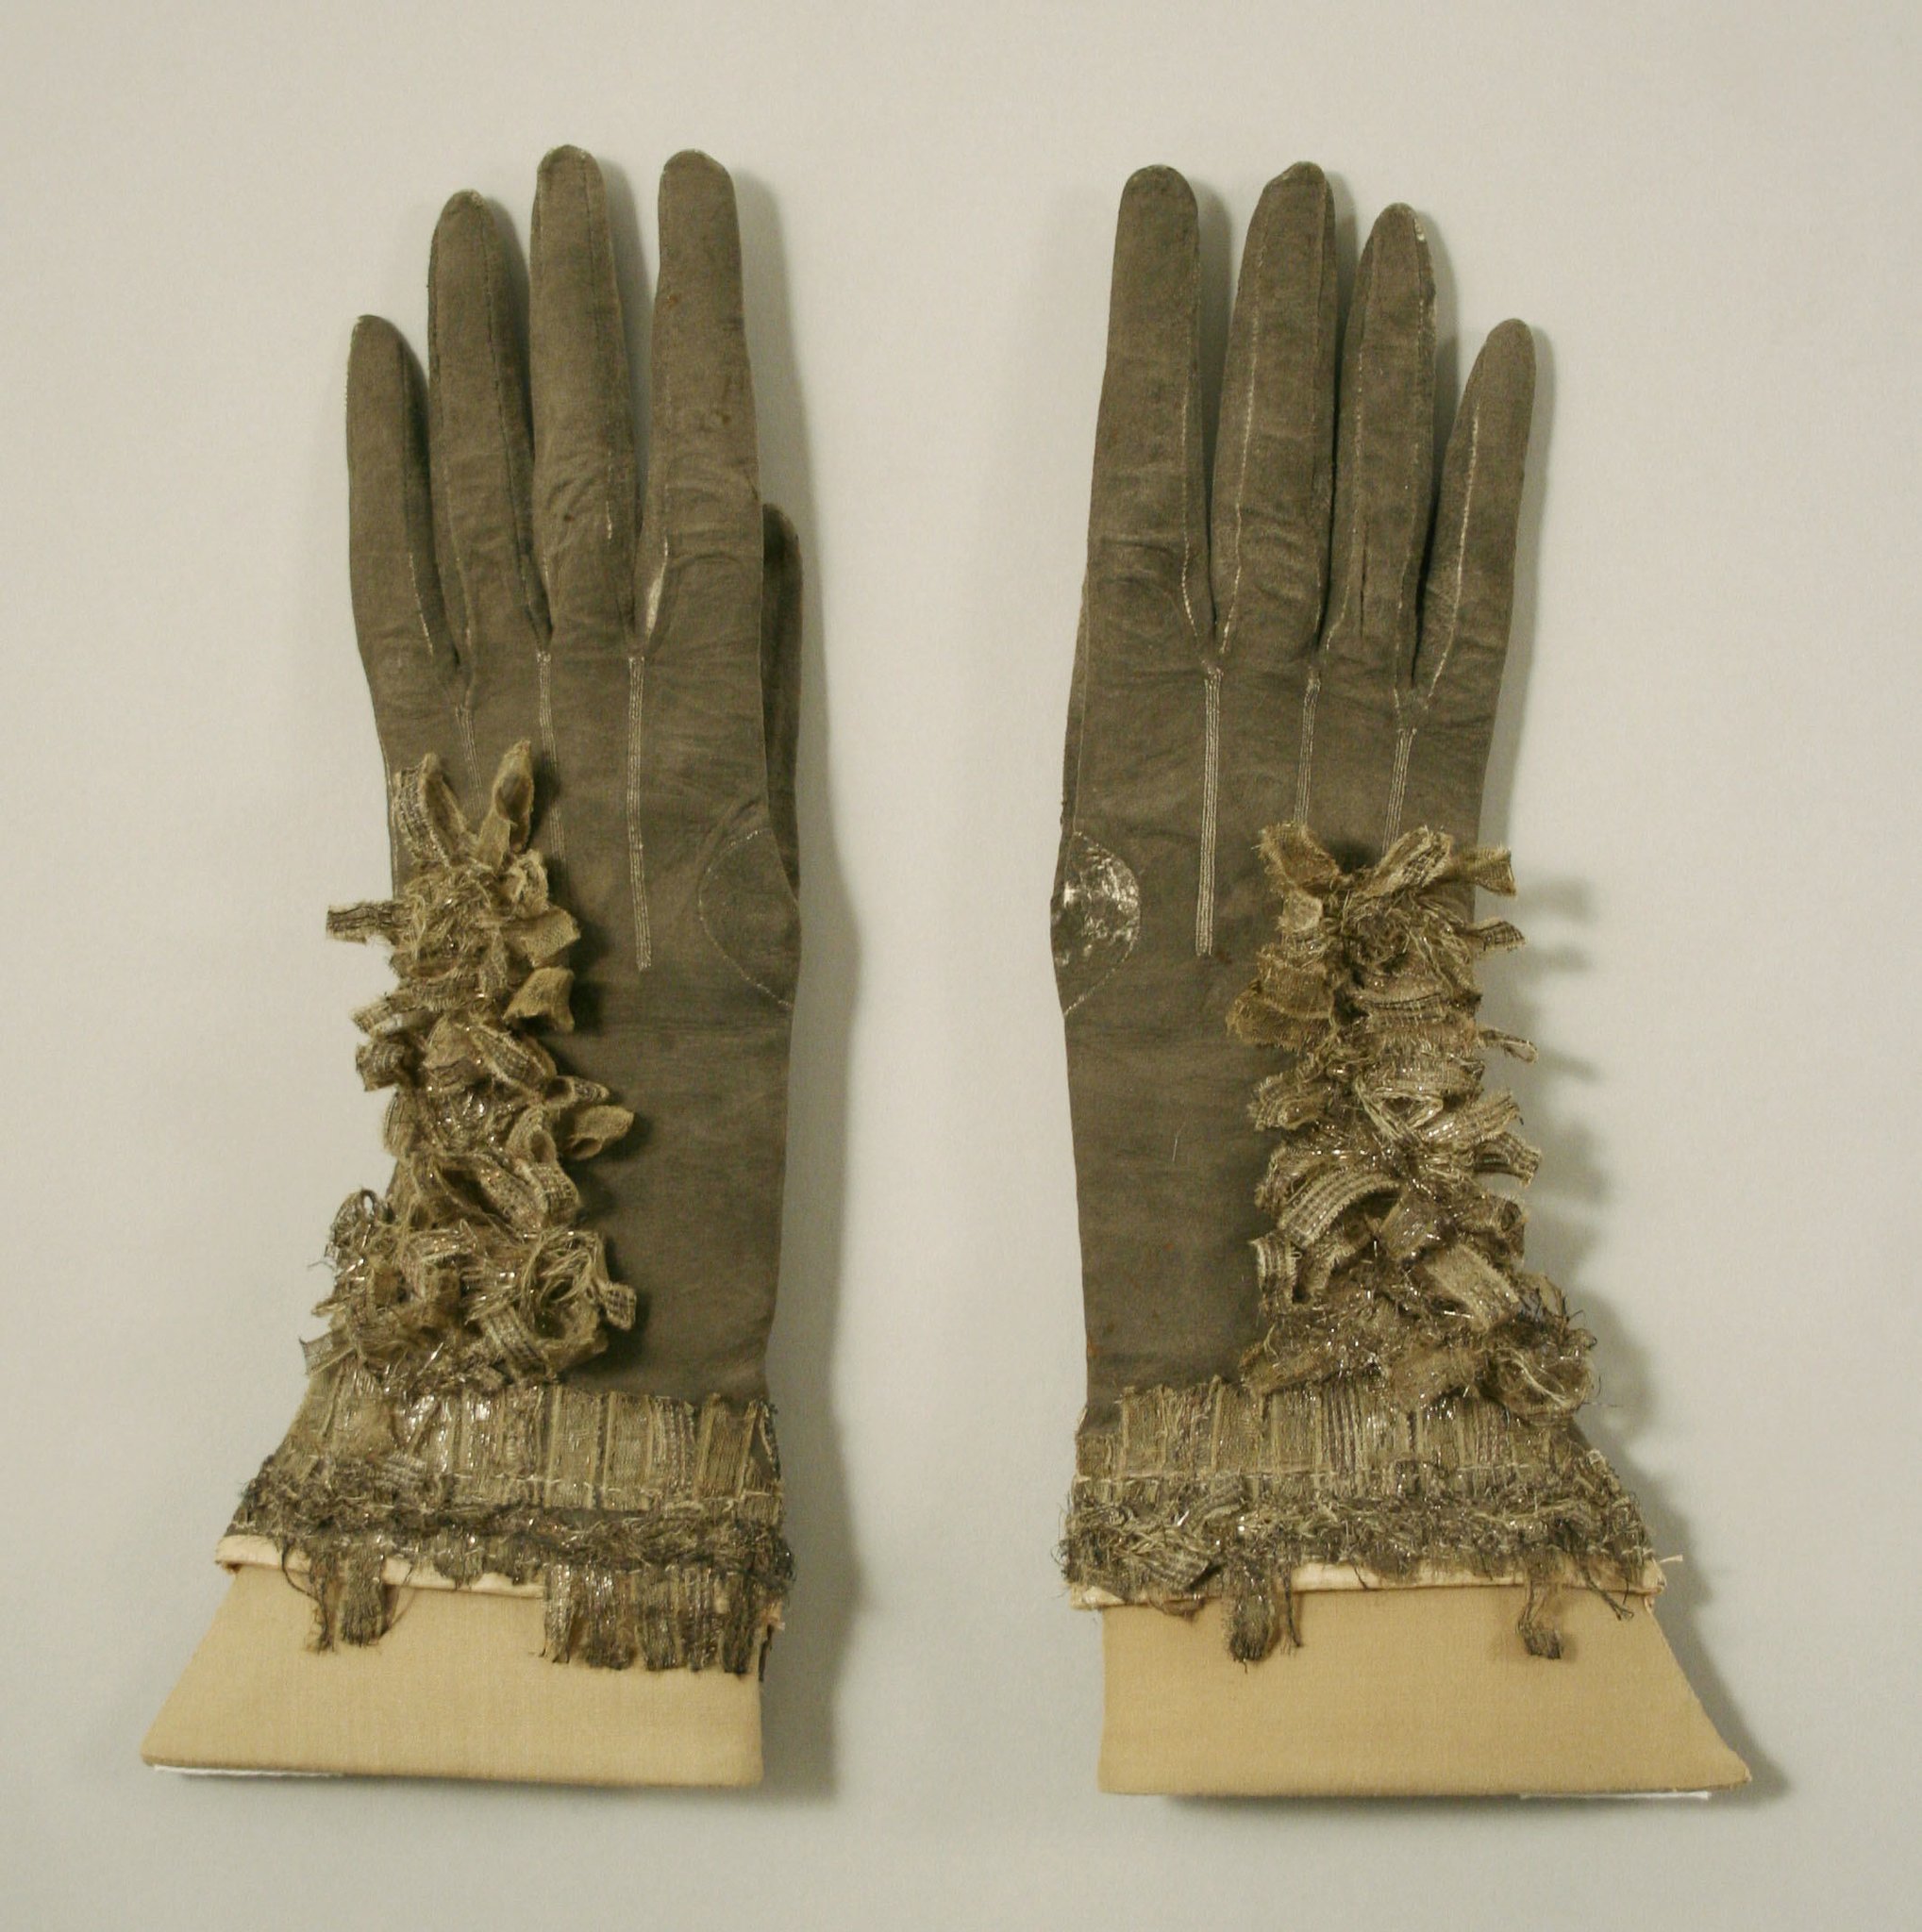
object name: glove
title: Gloves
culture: british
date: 1670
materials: leather, metal, silk